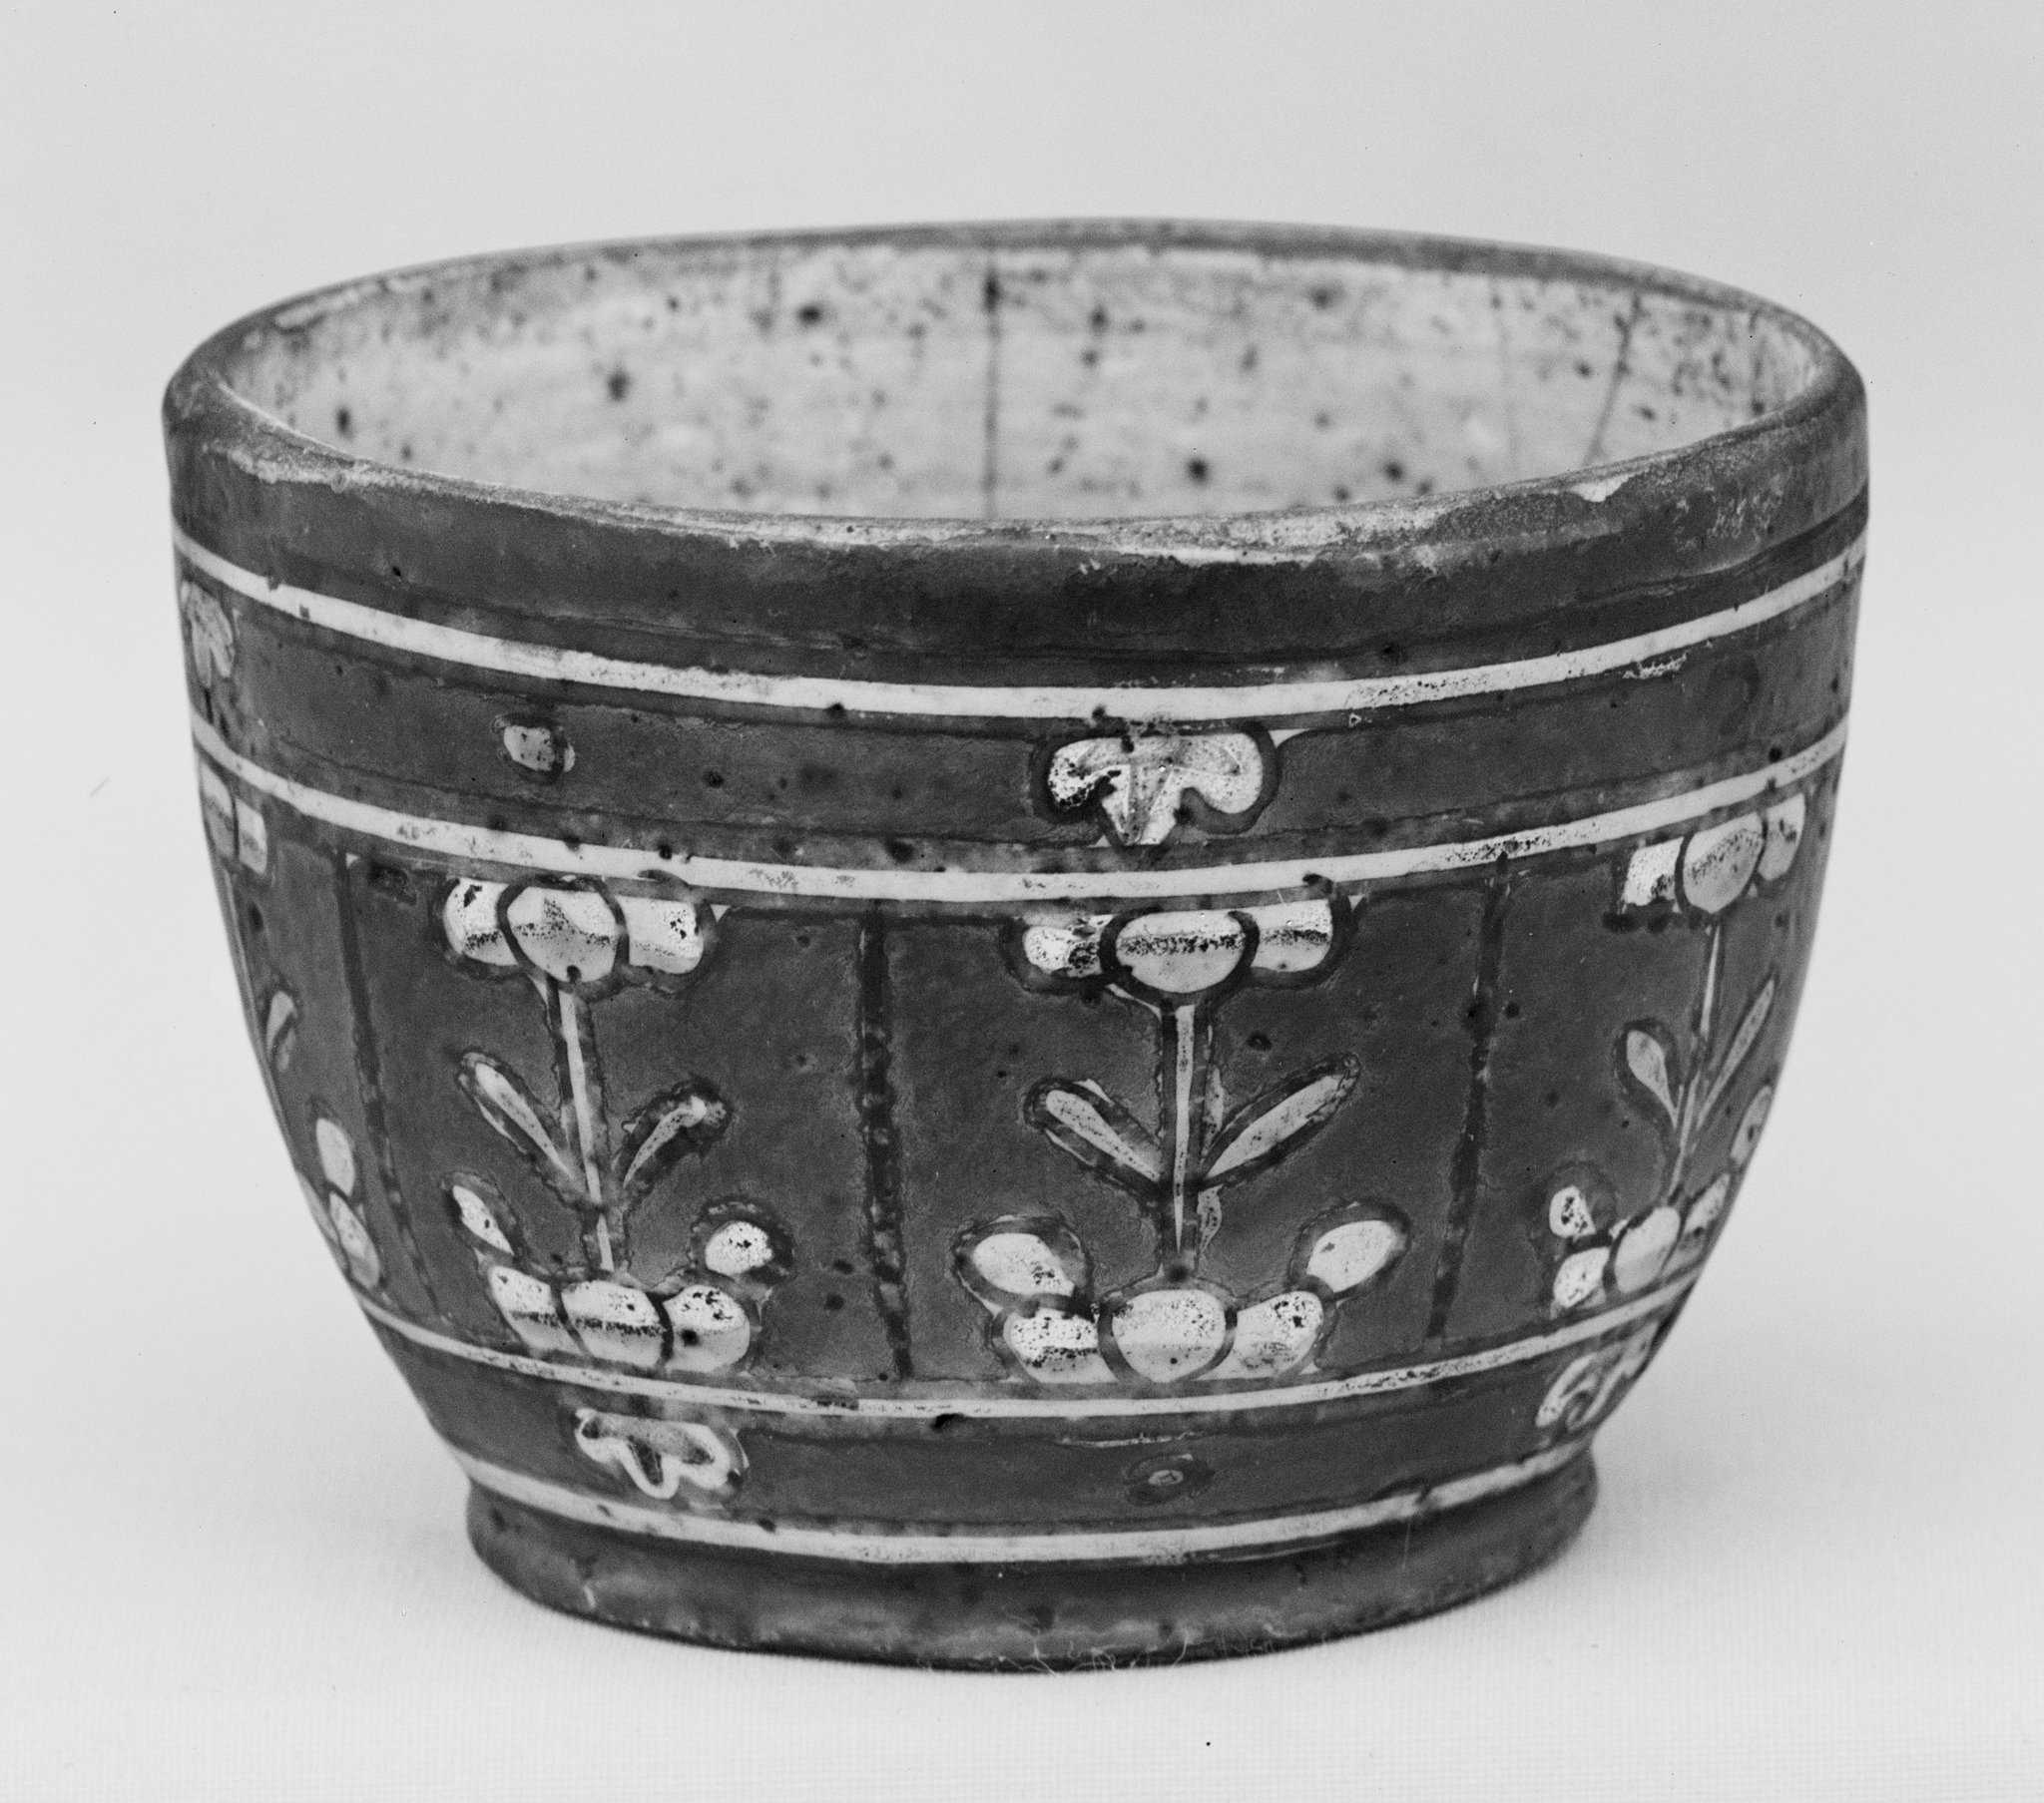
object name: cup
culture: japanese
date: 1701-1800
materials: glaze, pottery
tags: leaves